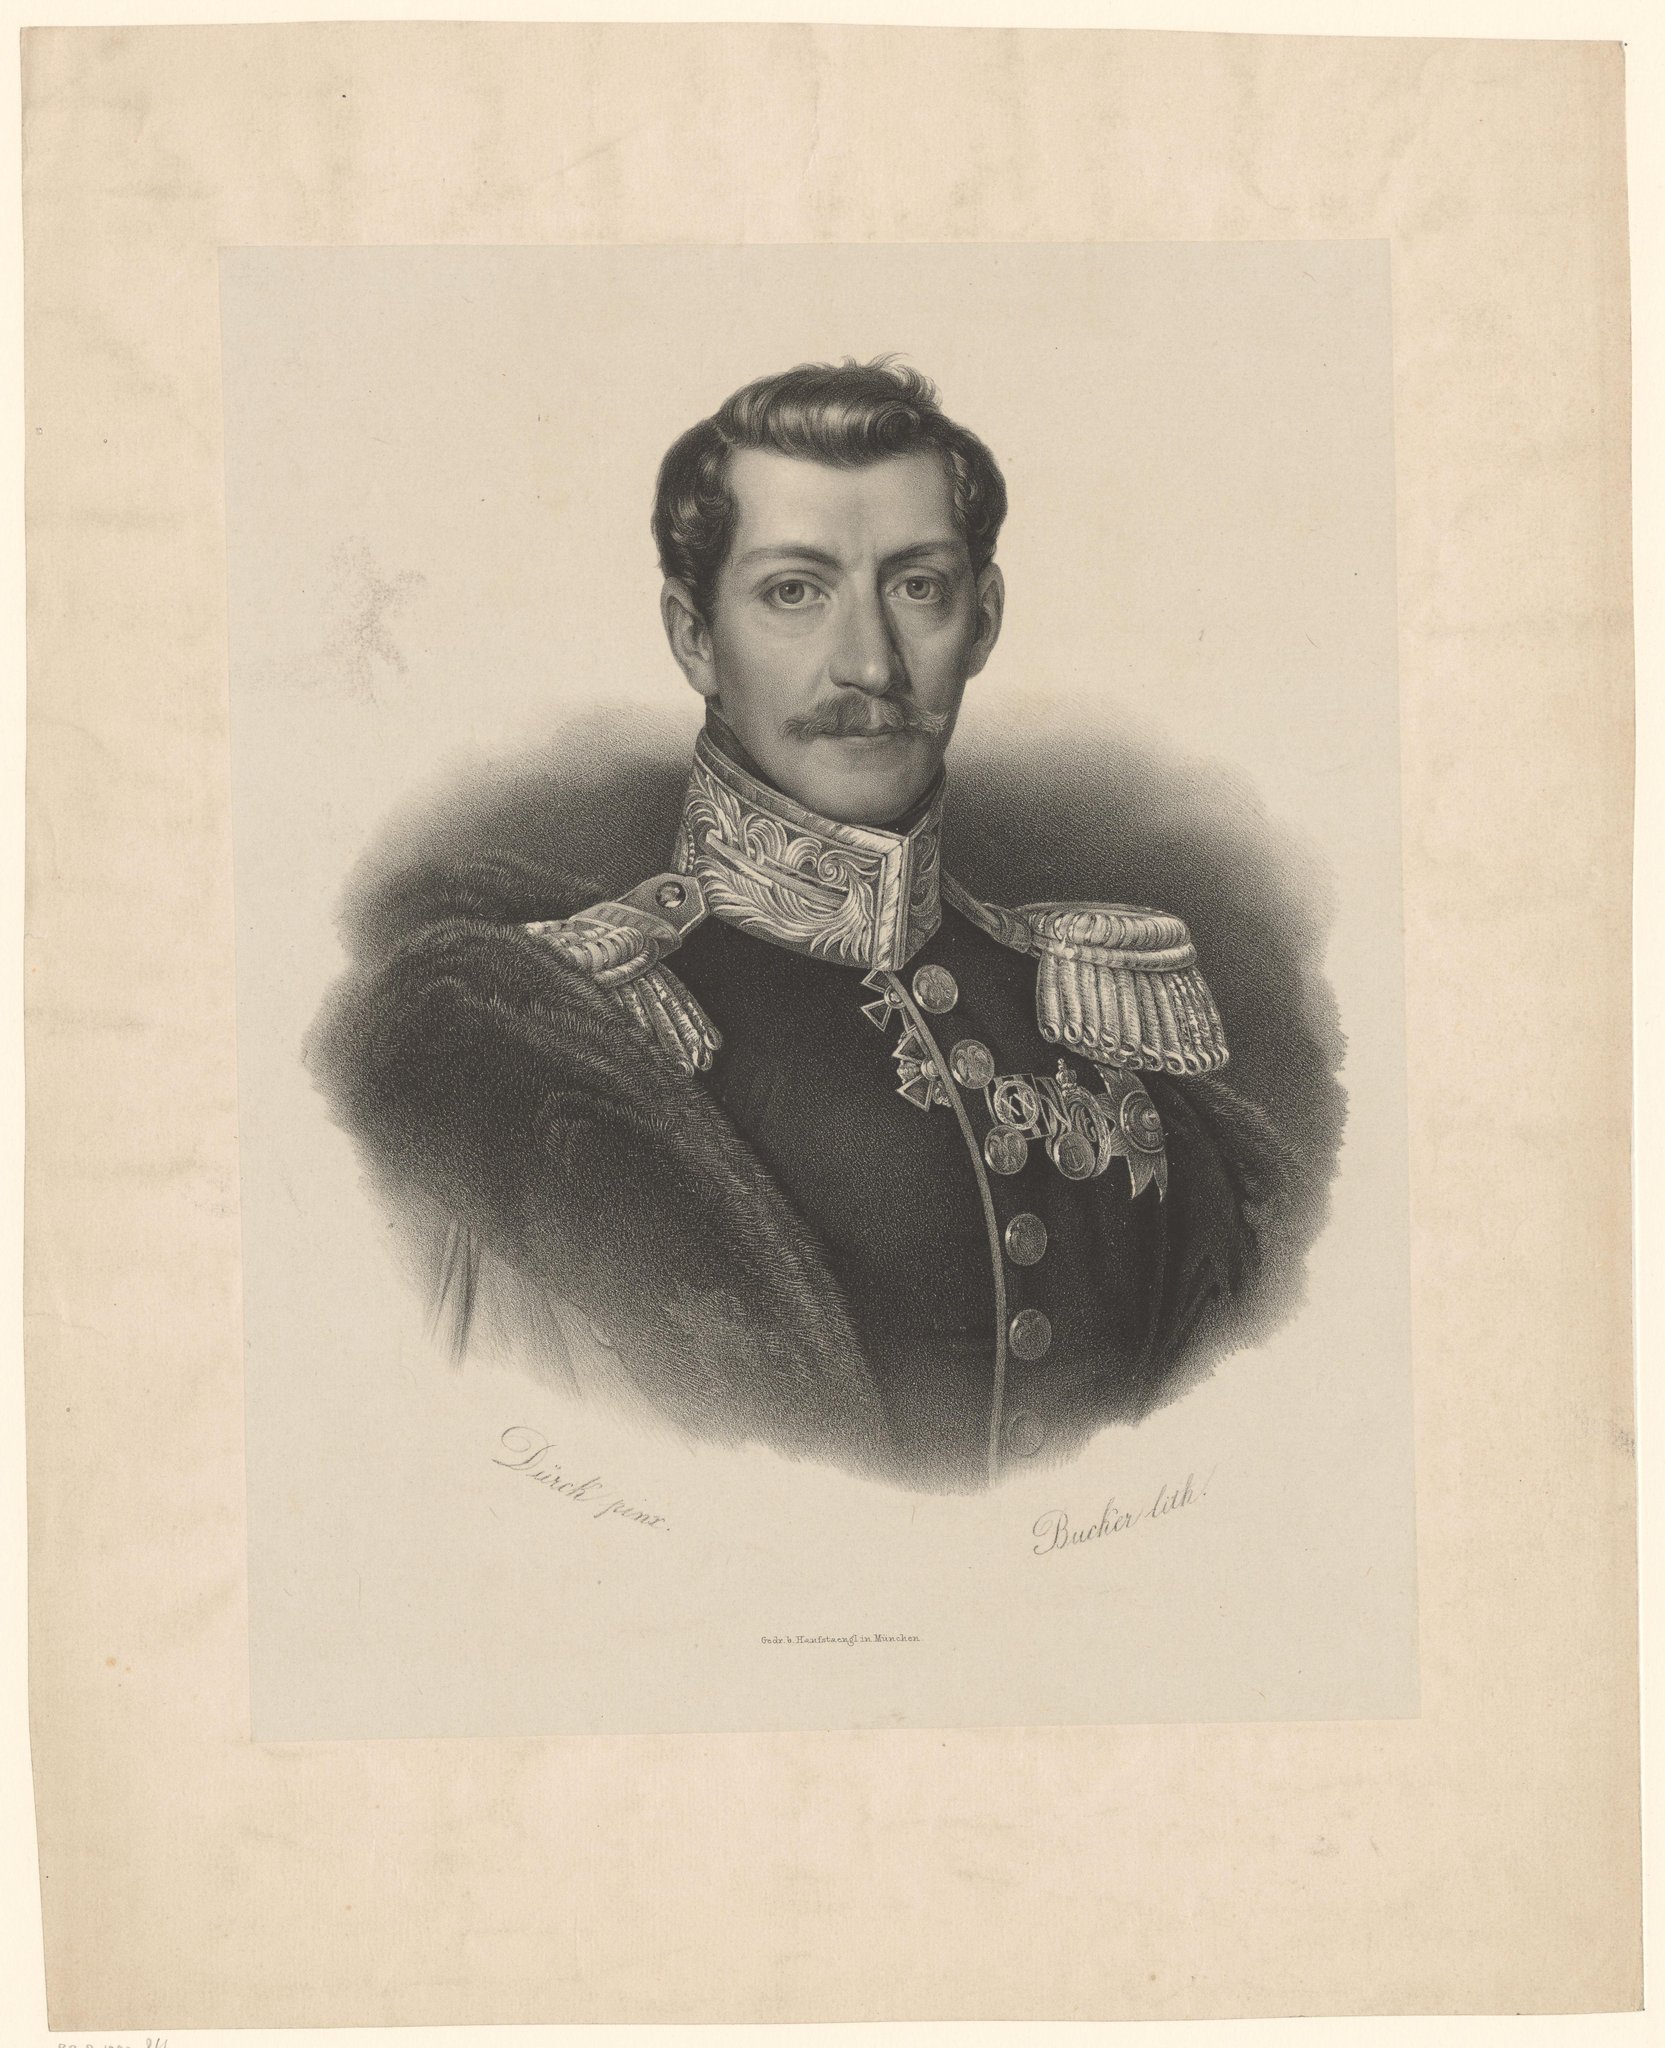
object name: print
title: Portret van een onbekende man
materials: paper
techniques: lithograph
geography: munich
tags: adult man, historical persons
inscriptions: collector's mark: Lugt 2228, collector's mark: Lugt 2760